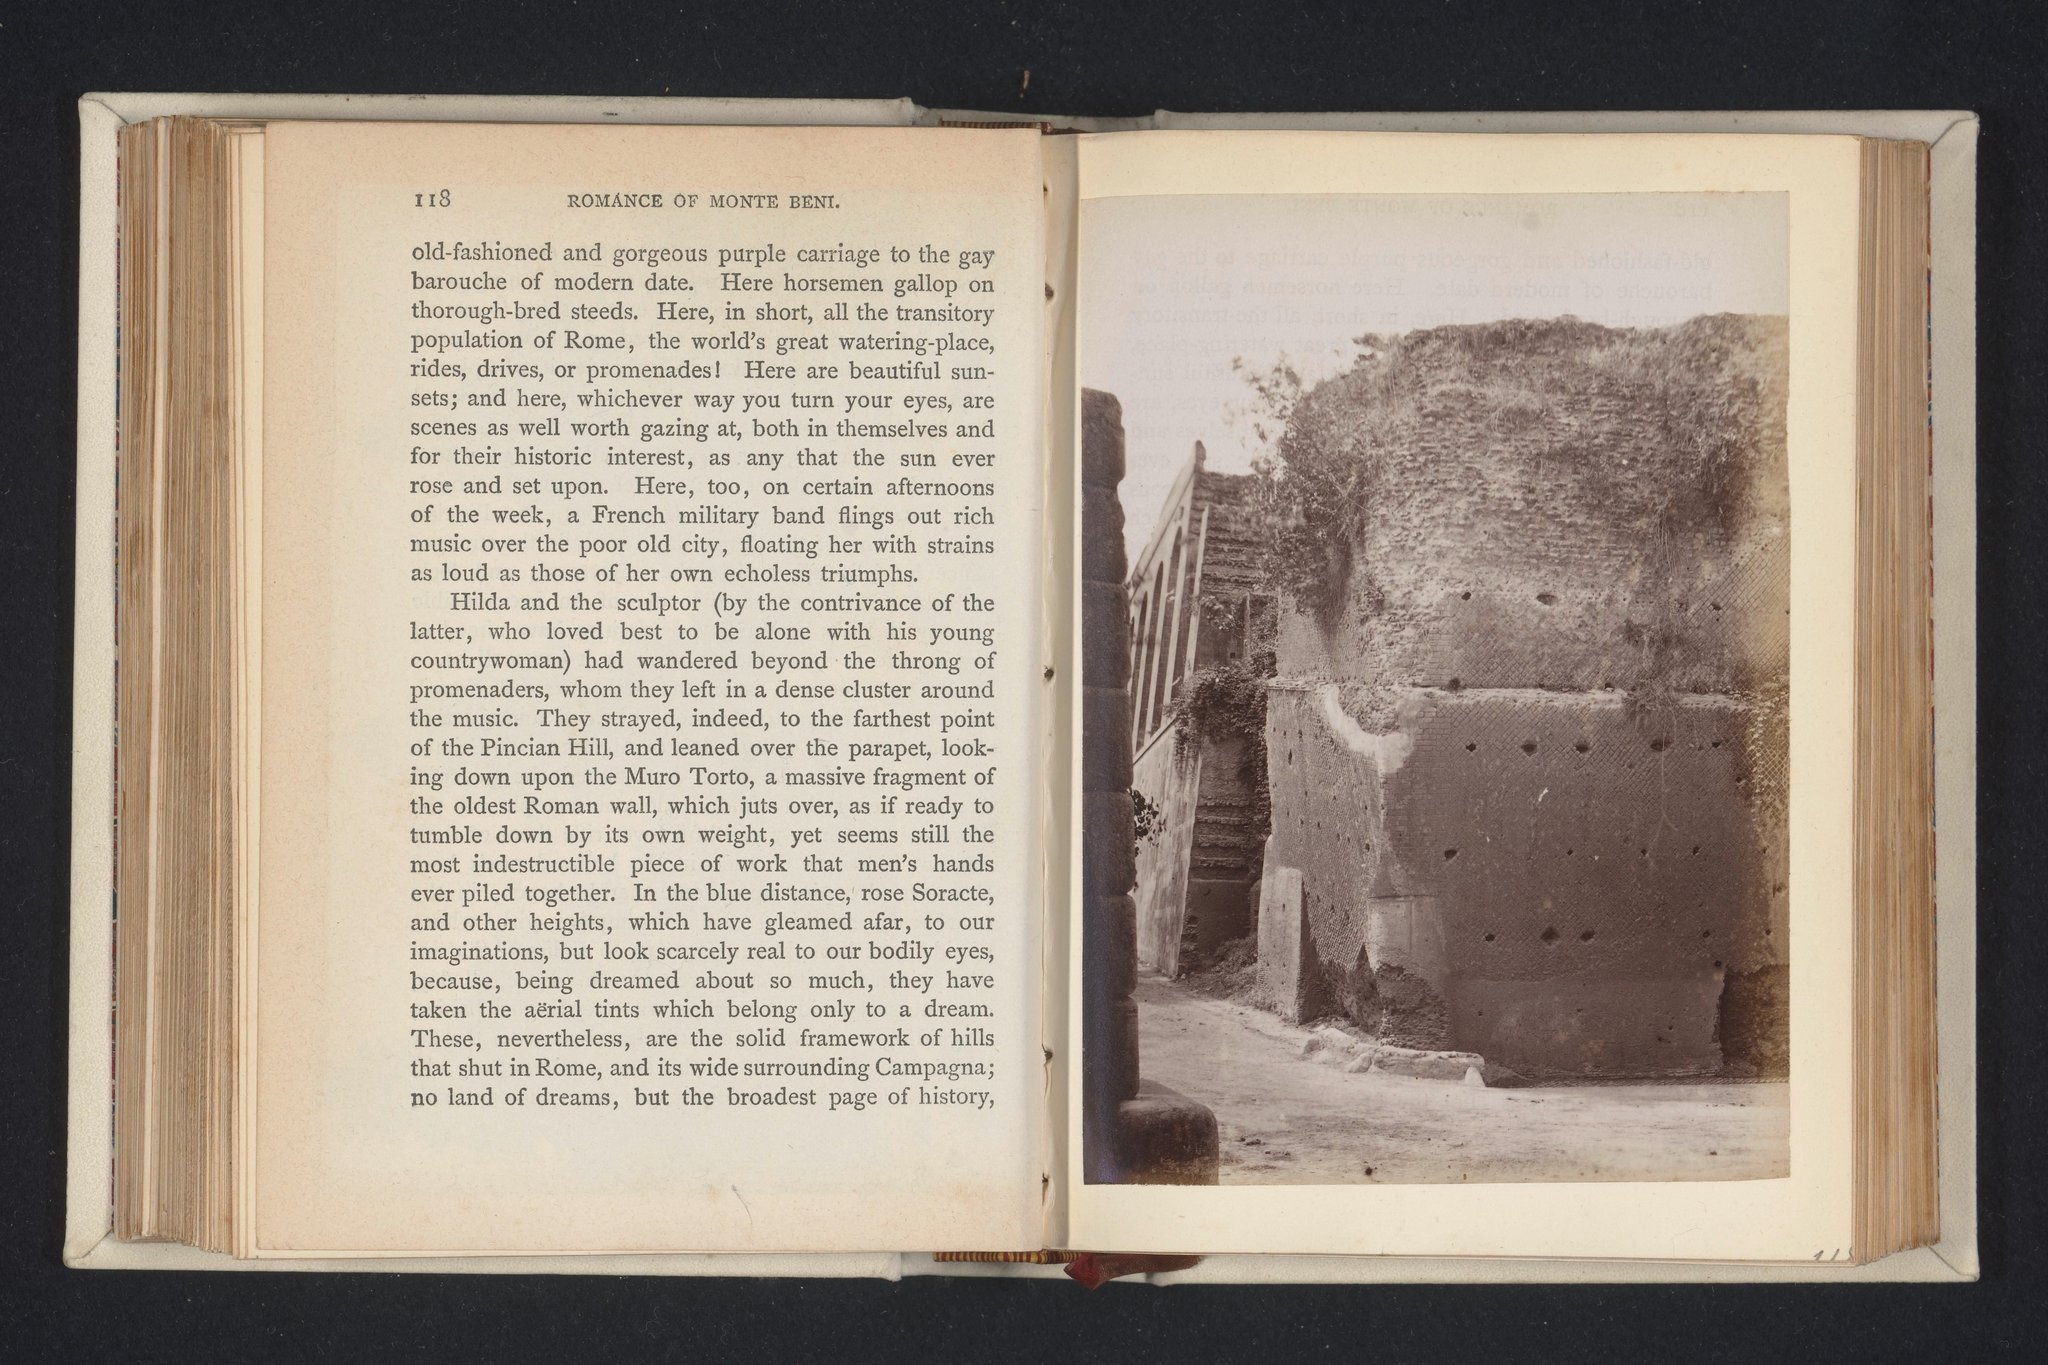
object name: photograph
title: Gezicht op een stuk van de Muro Torto, de oude stadsmuur van Rome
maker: Anonymous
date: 1850-1860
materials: photographic support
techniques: albumen print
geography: rome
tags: city-walls, rome